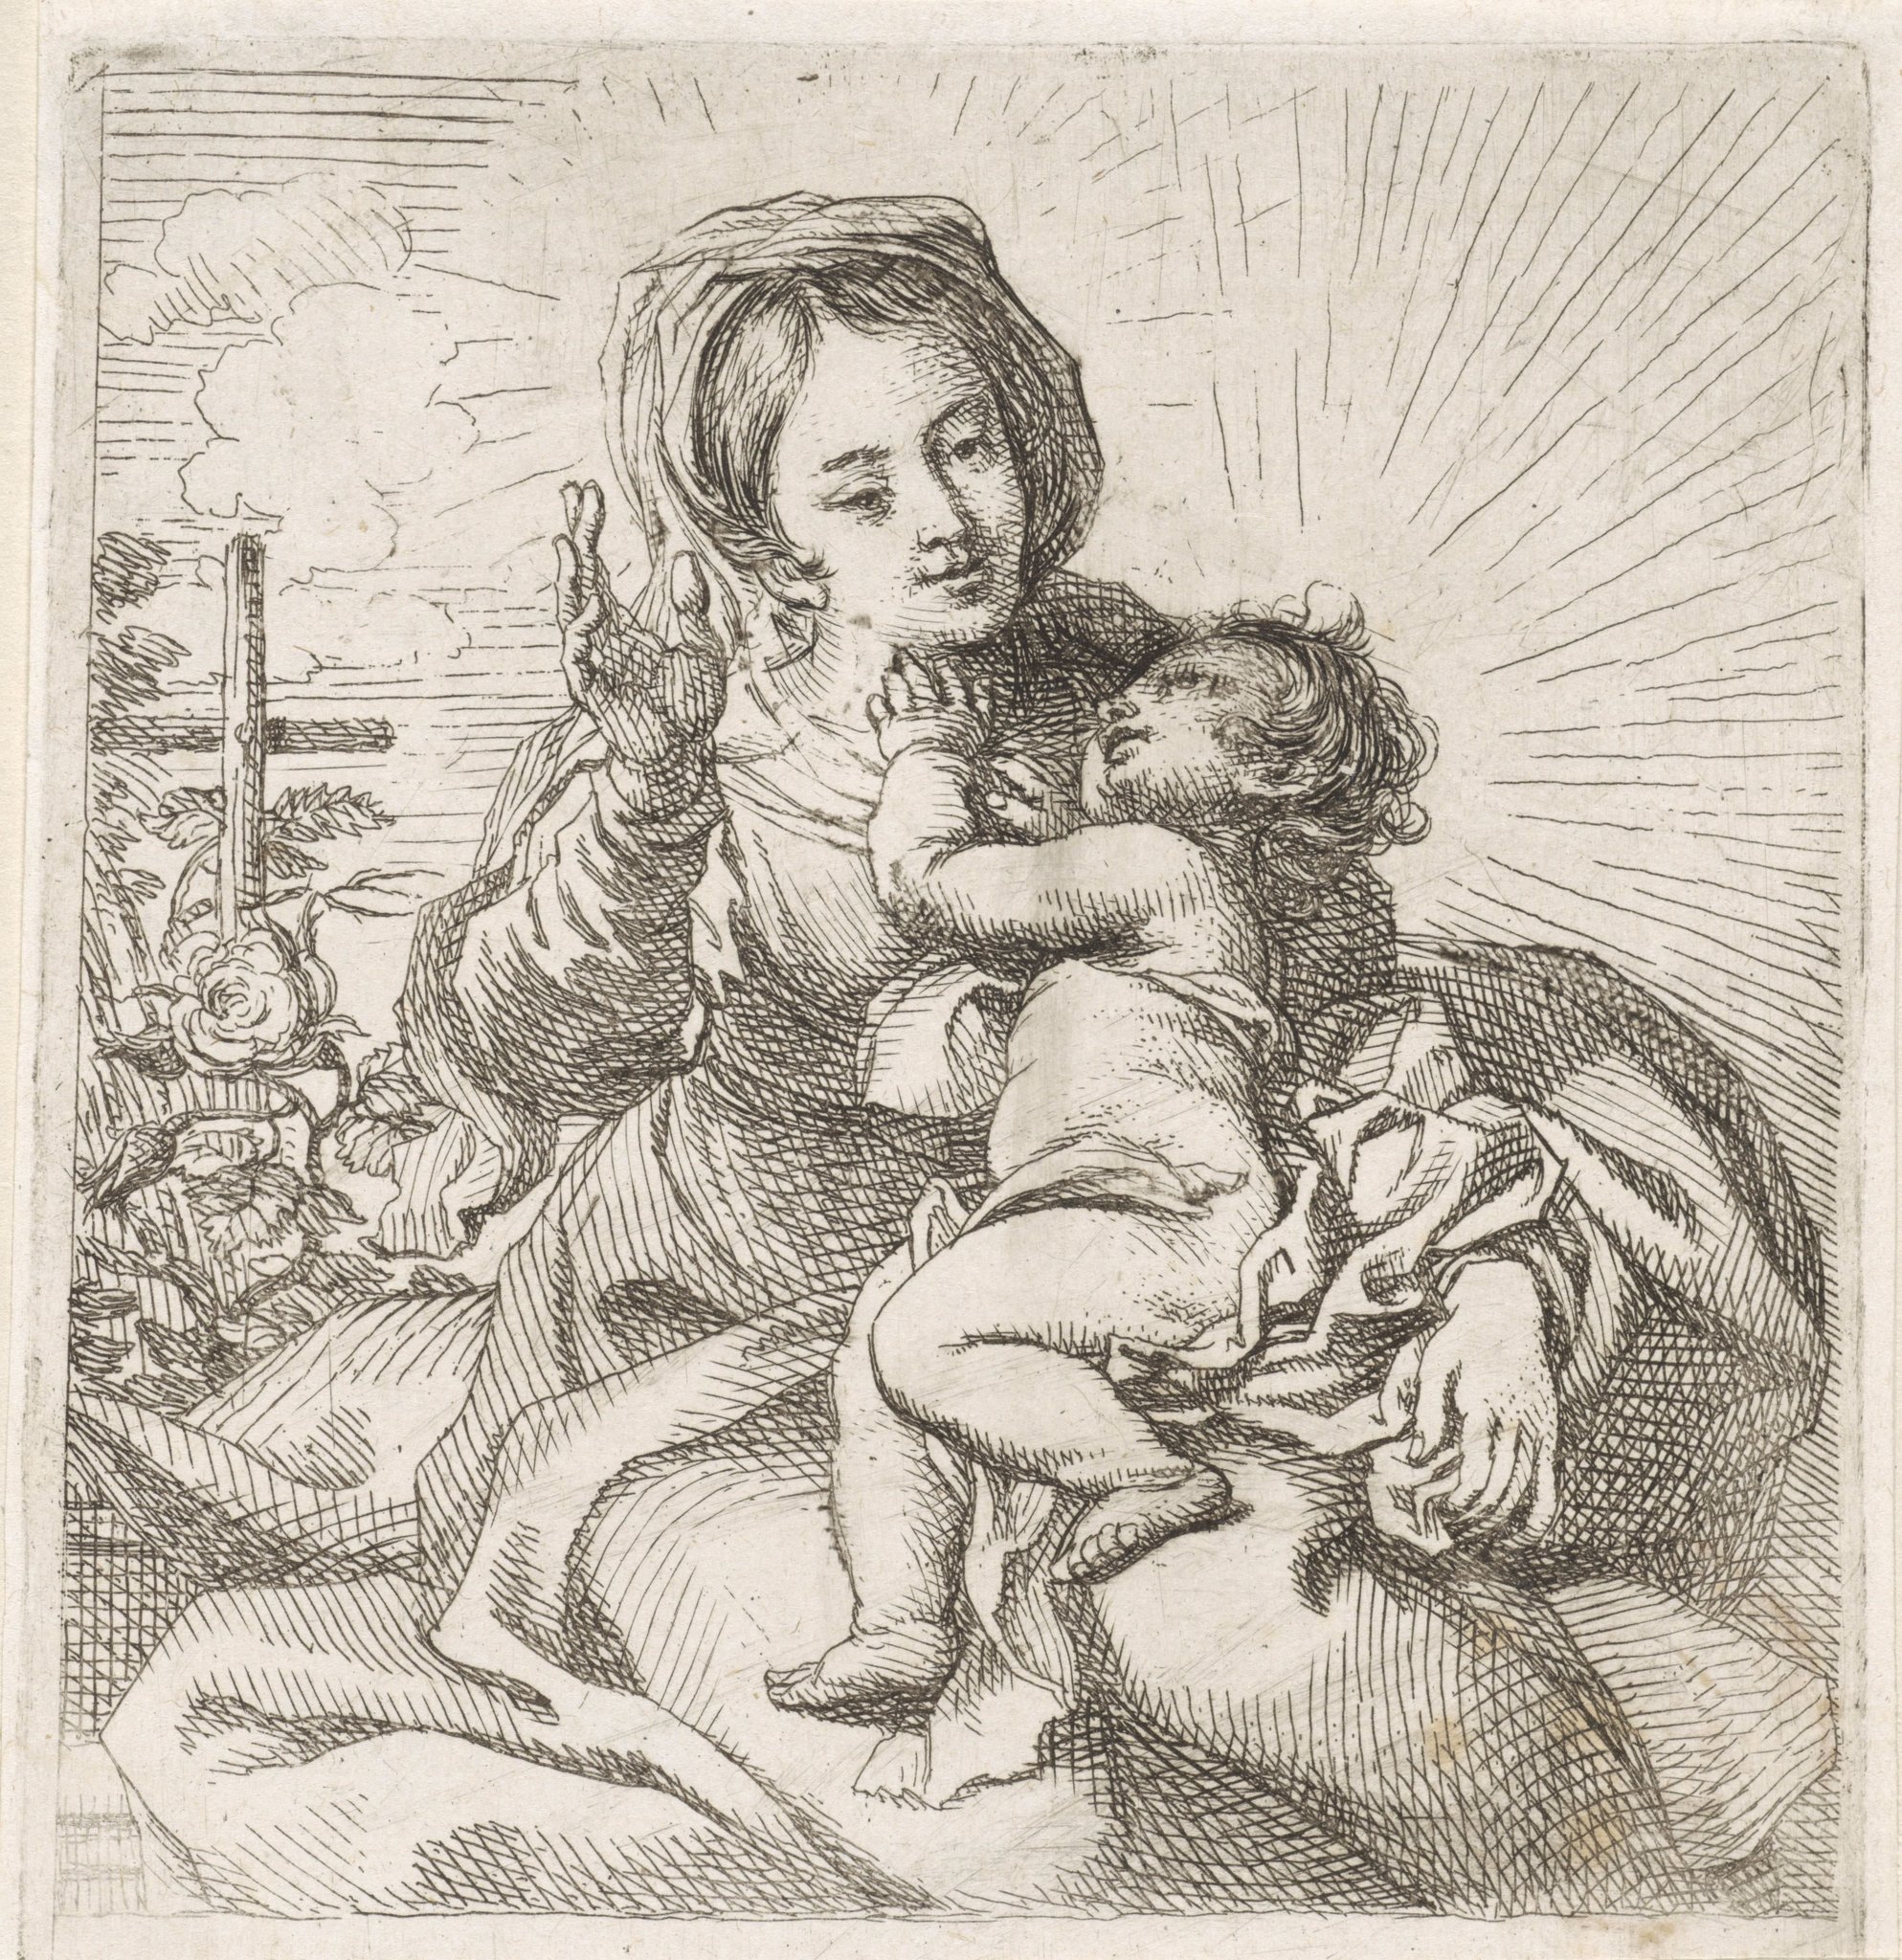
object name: print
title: Madonna met kind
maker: cornelis schut (i)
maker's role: draughtsman, print maker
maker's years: 1597-1655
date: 1618-1655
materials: paper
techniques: etching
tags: madonna: i.e. mary with the christ-child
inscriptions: collector's mark: Lugt 240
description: Het Christuskind ligt op schoot bij Maria, zijn hoofd op haar schouder. Op de achtergrond het kruis waarlangs een rozenstruik zich naar boven slingert.